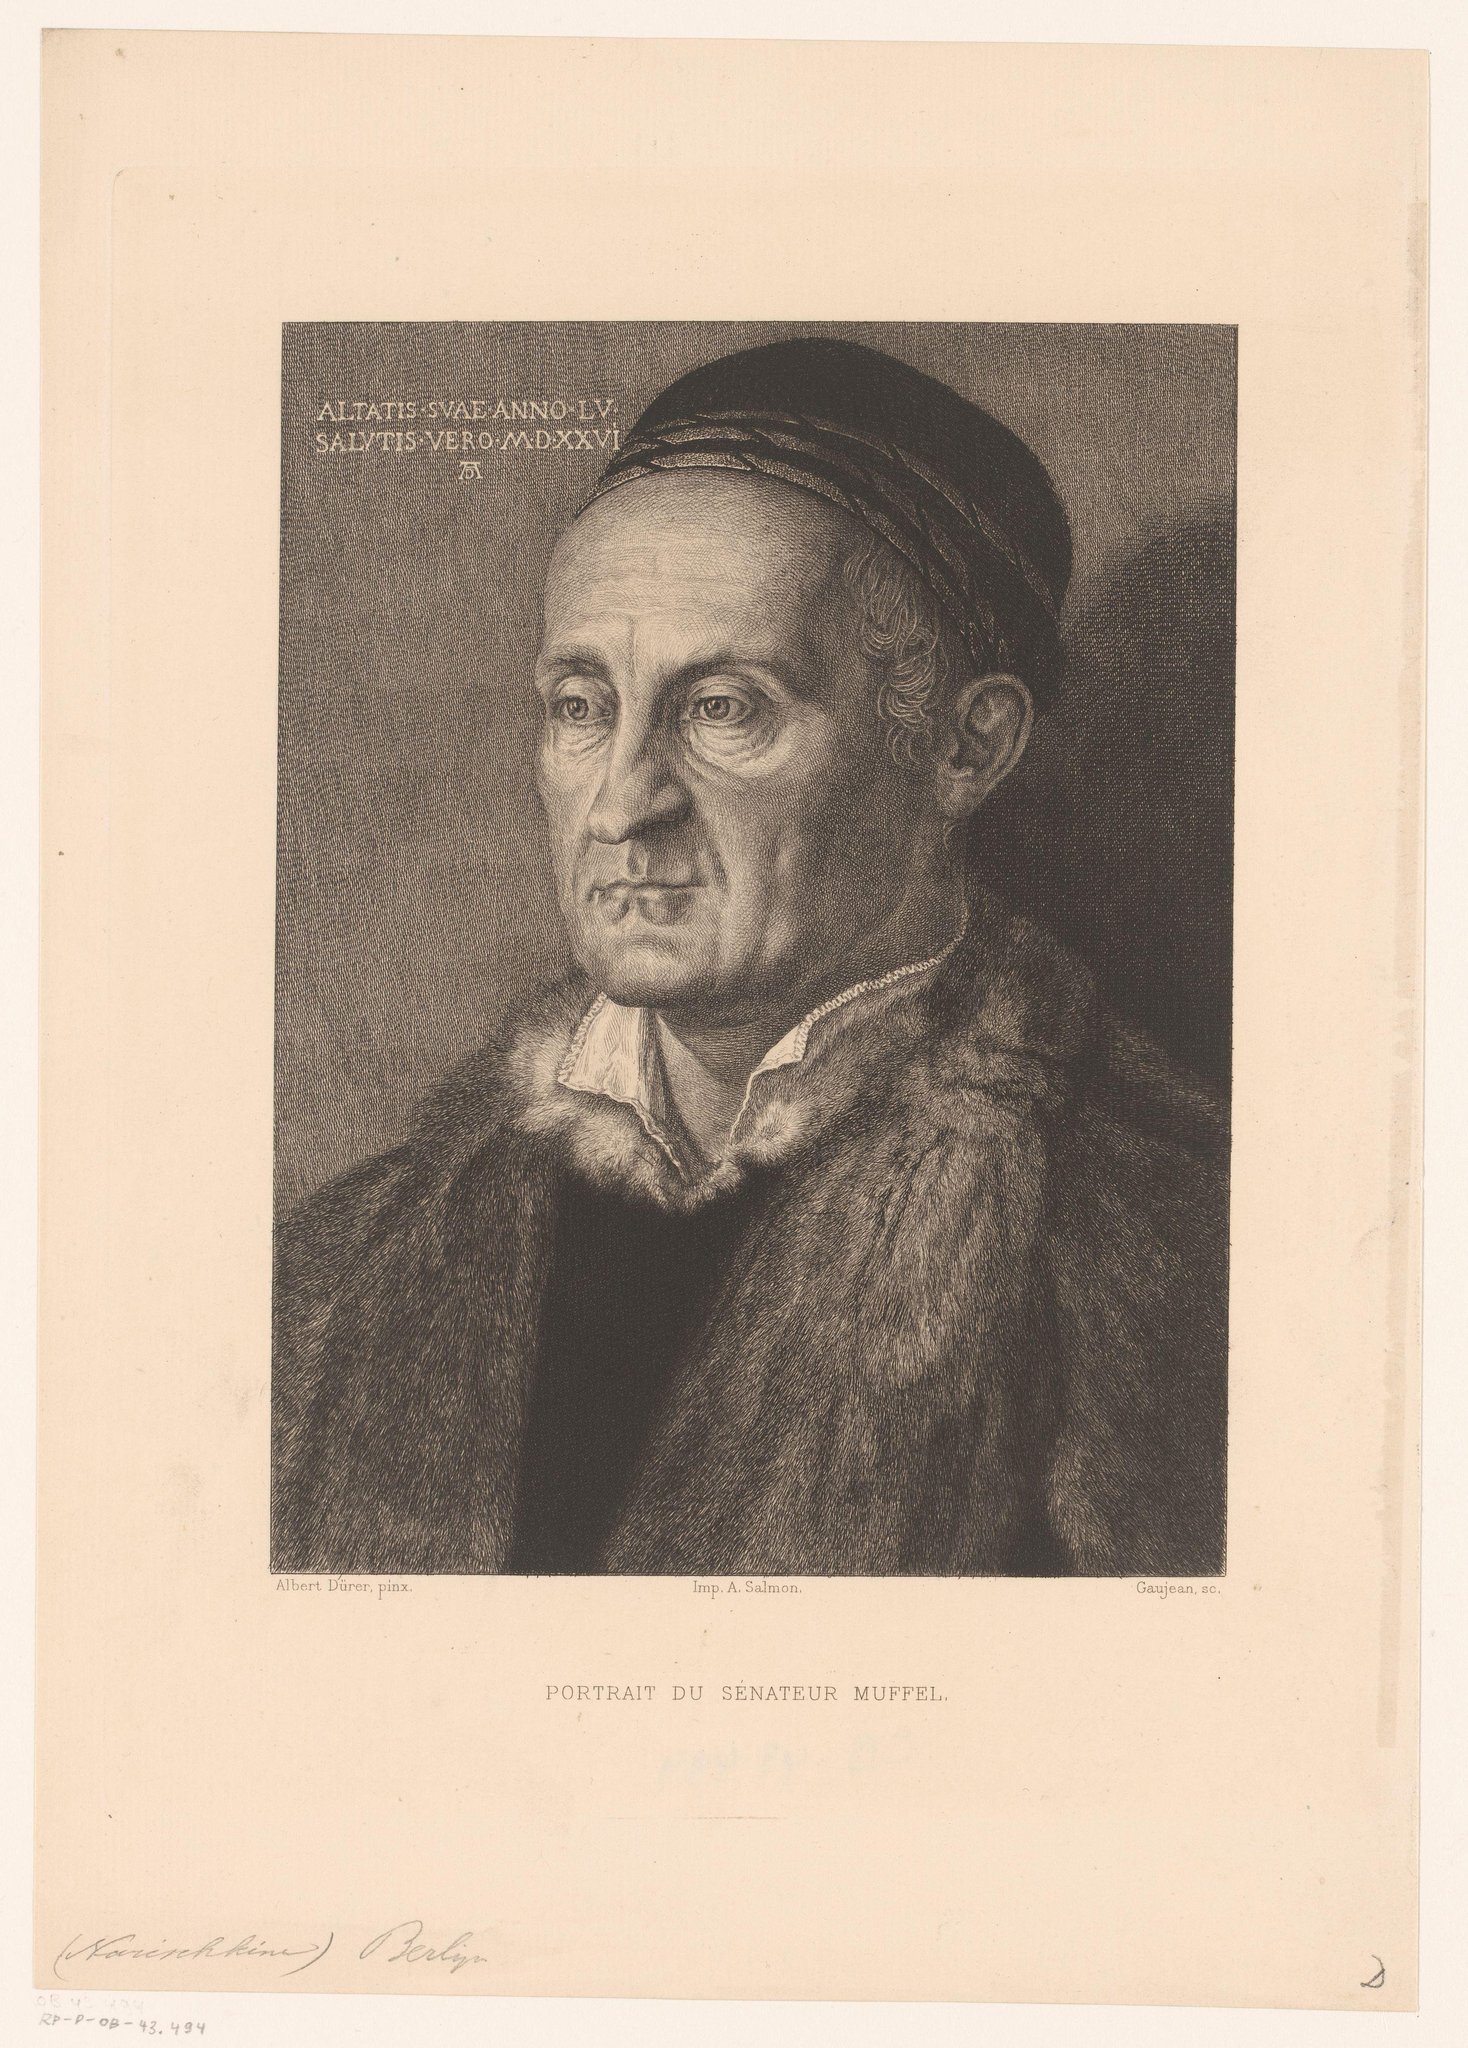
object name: print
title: Portrait du sénateur Muffel.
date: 1860-1900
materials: paper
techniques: engraving, etching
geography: france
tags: historical persons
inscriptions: collector's mark: Lugt 2228